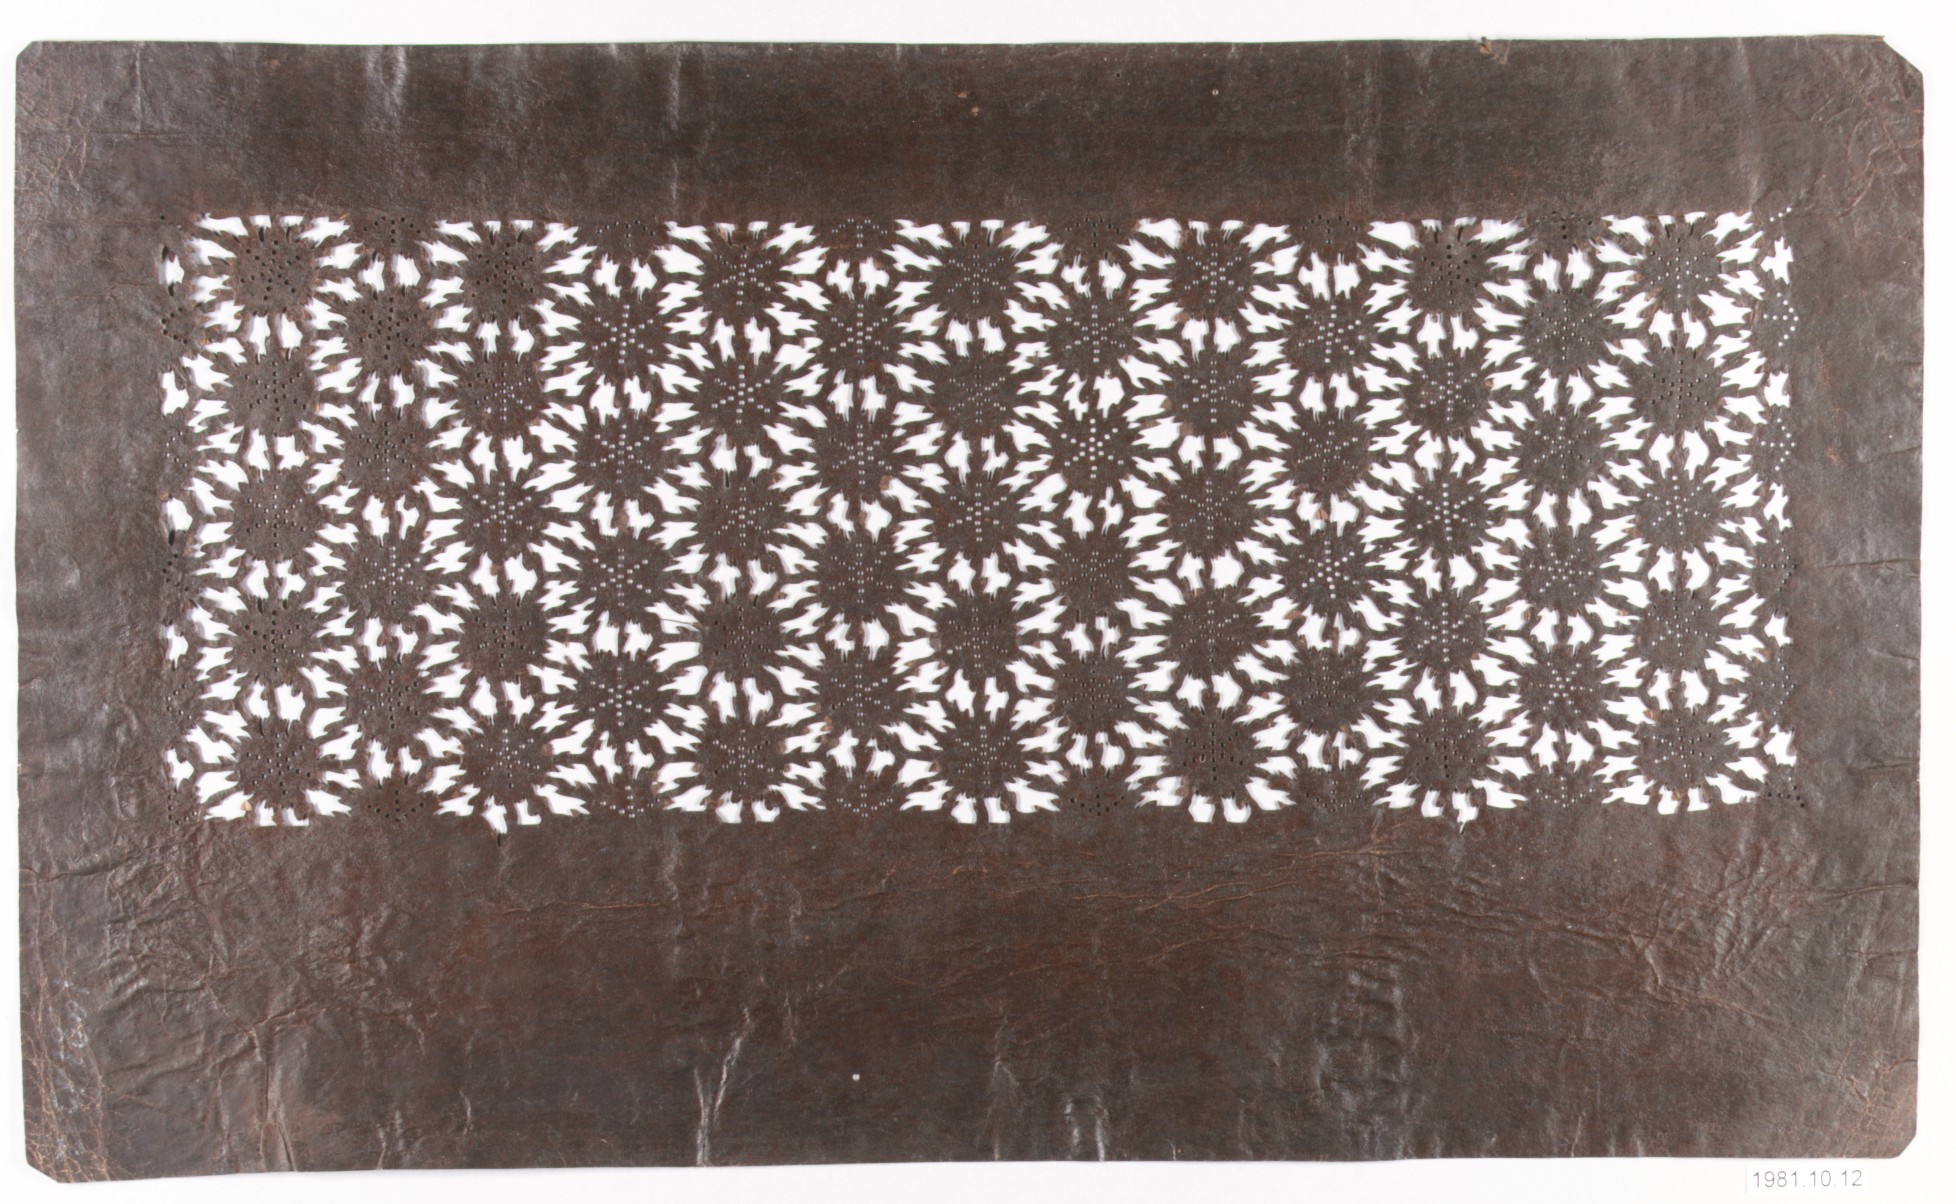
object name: stencil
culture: japanese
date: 1801-1900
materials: paper